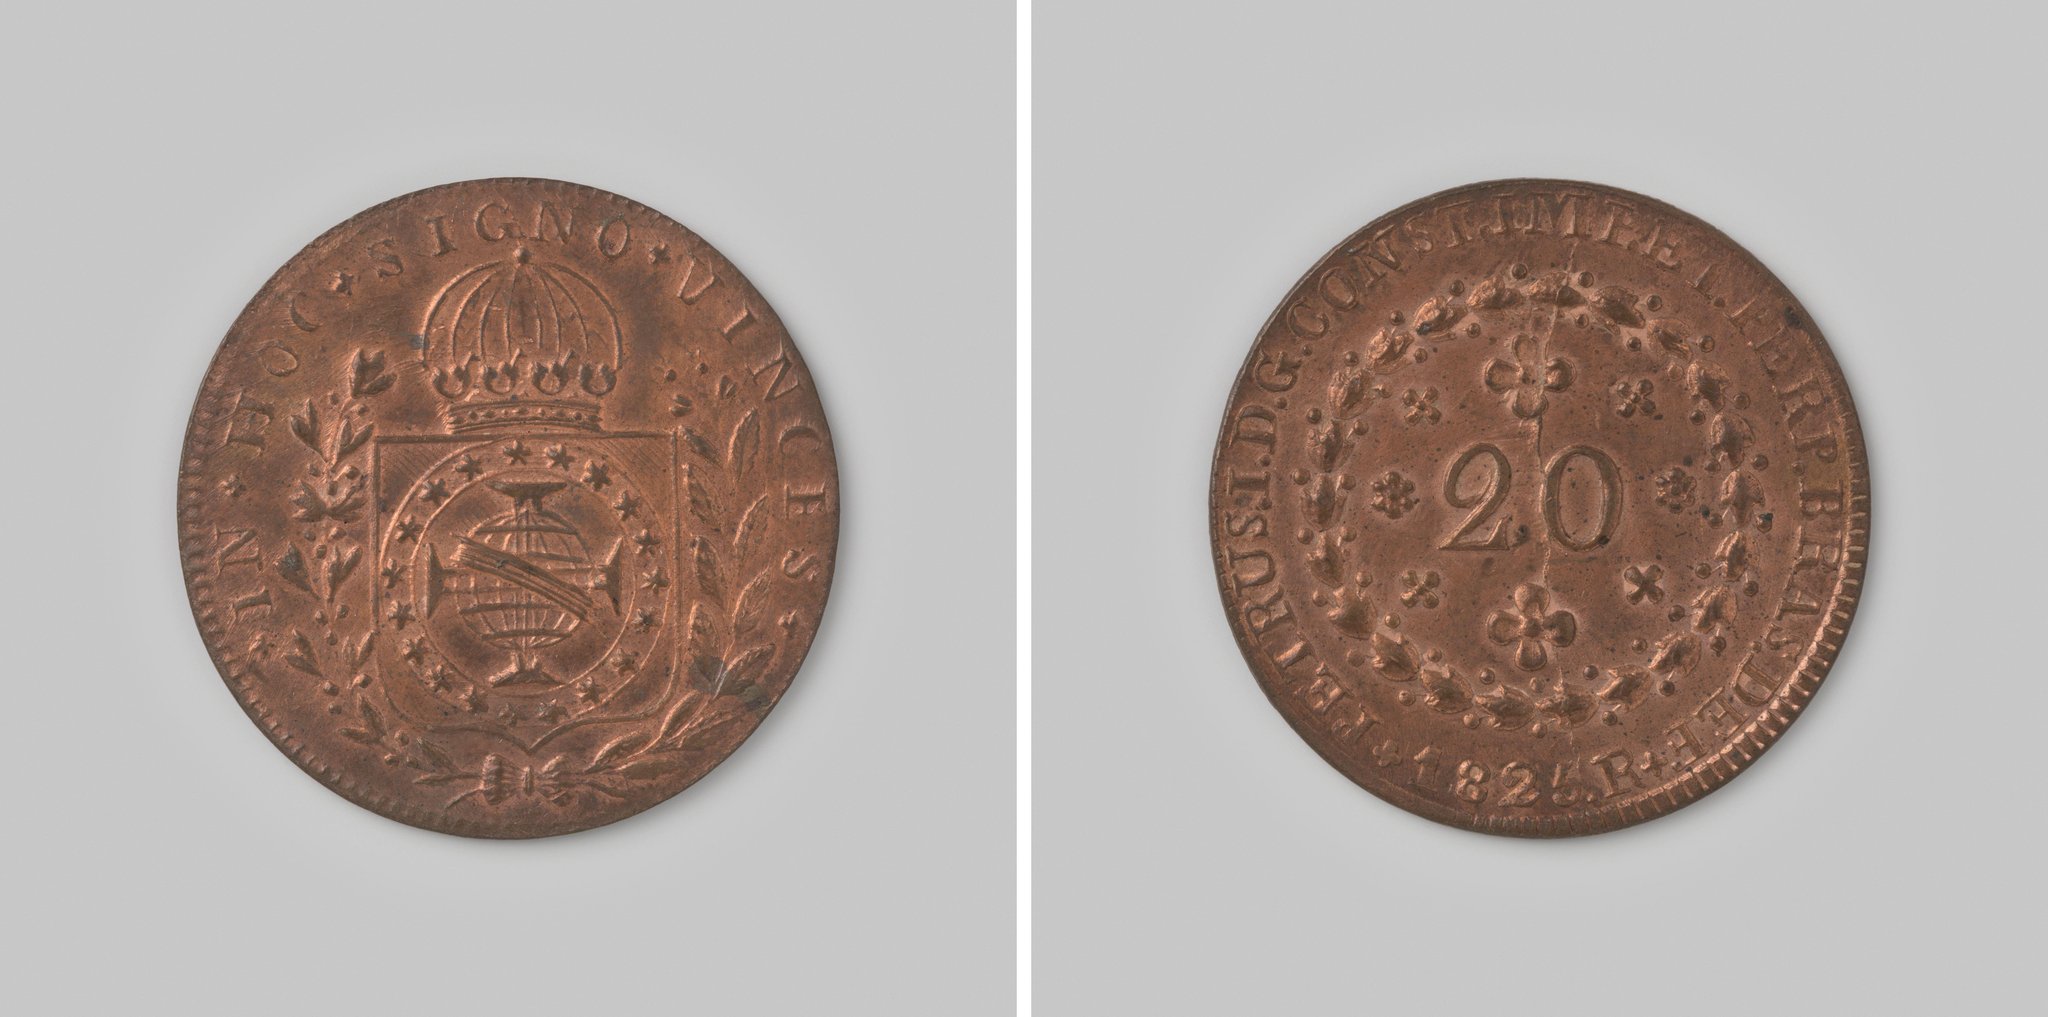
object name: coin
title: 20 reis van het keizerrijk Brazilië van D. Pedro I, 1825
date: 1825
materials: copper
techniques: striking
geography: rio de janeiro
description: Koperen munt. Voorzijde: tussen twee samengebonden takken gekroond wapenschild van Brazilië. Keerzijde: binnen cirkel van bloemen waarde-aanduiding: 20. In omschrift onderaan jaartal met rechts daarvan letter R [=Rio]. Gladde rand.